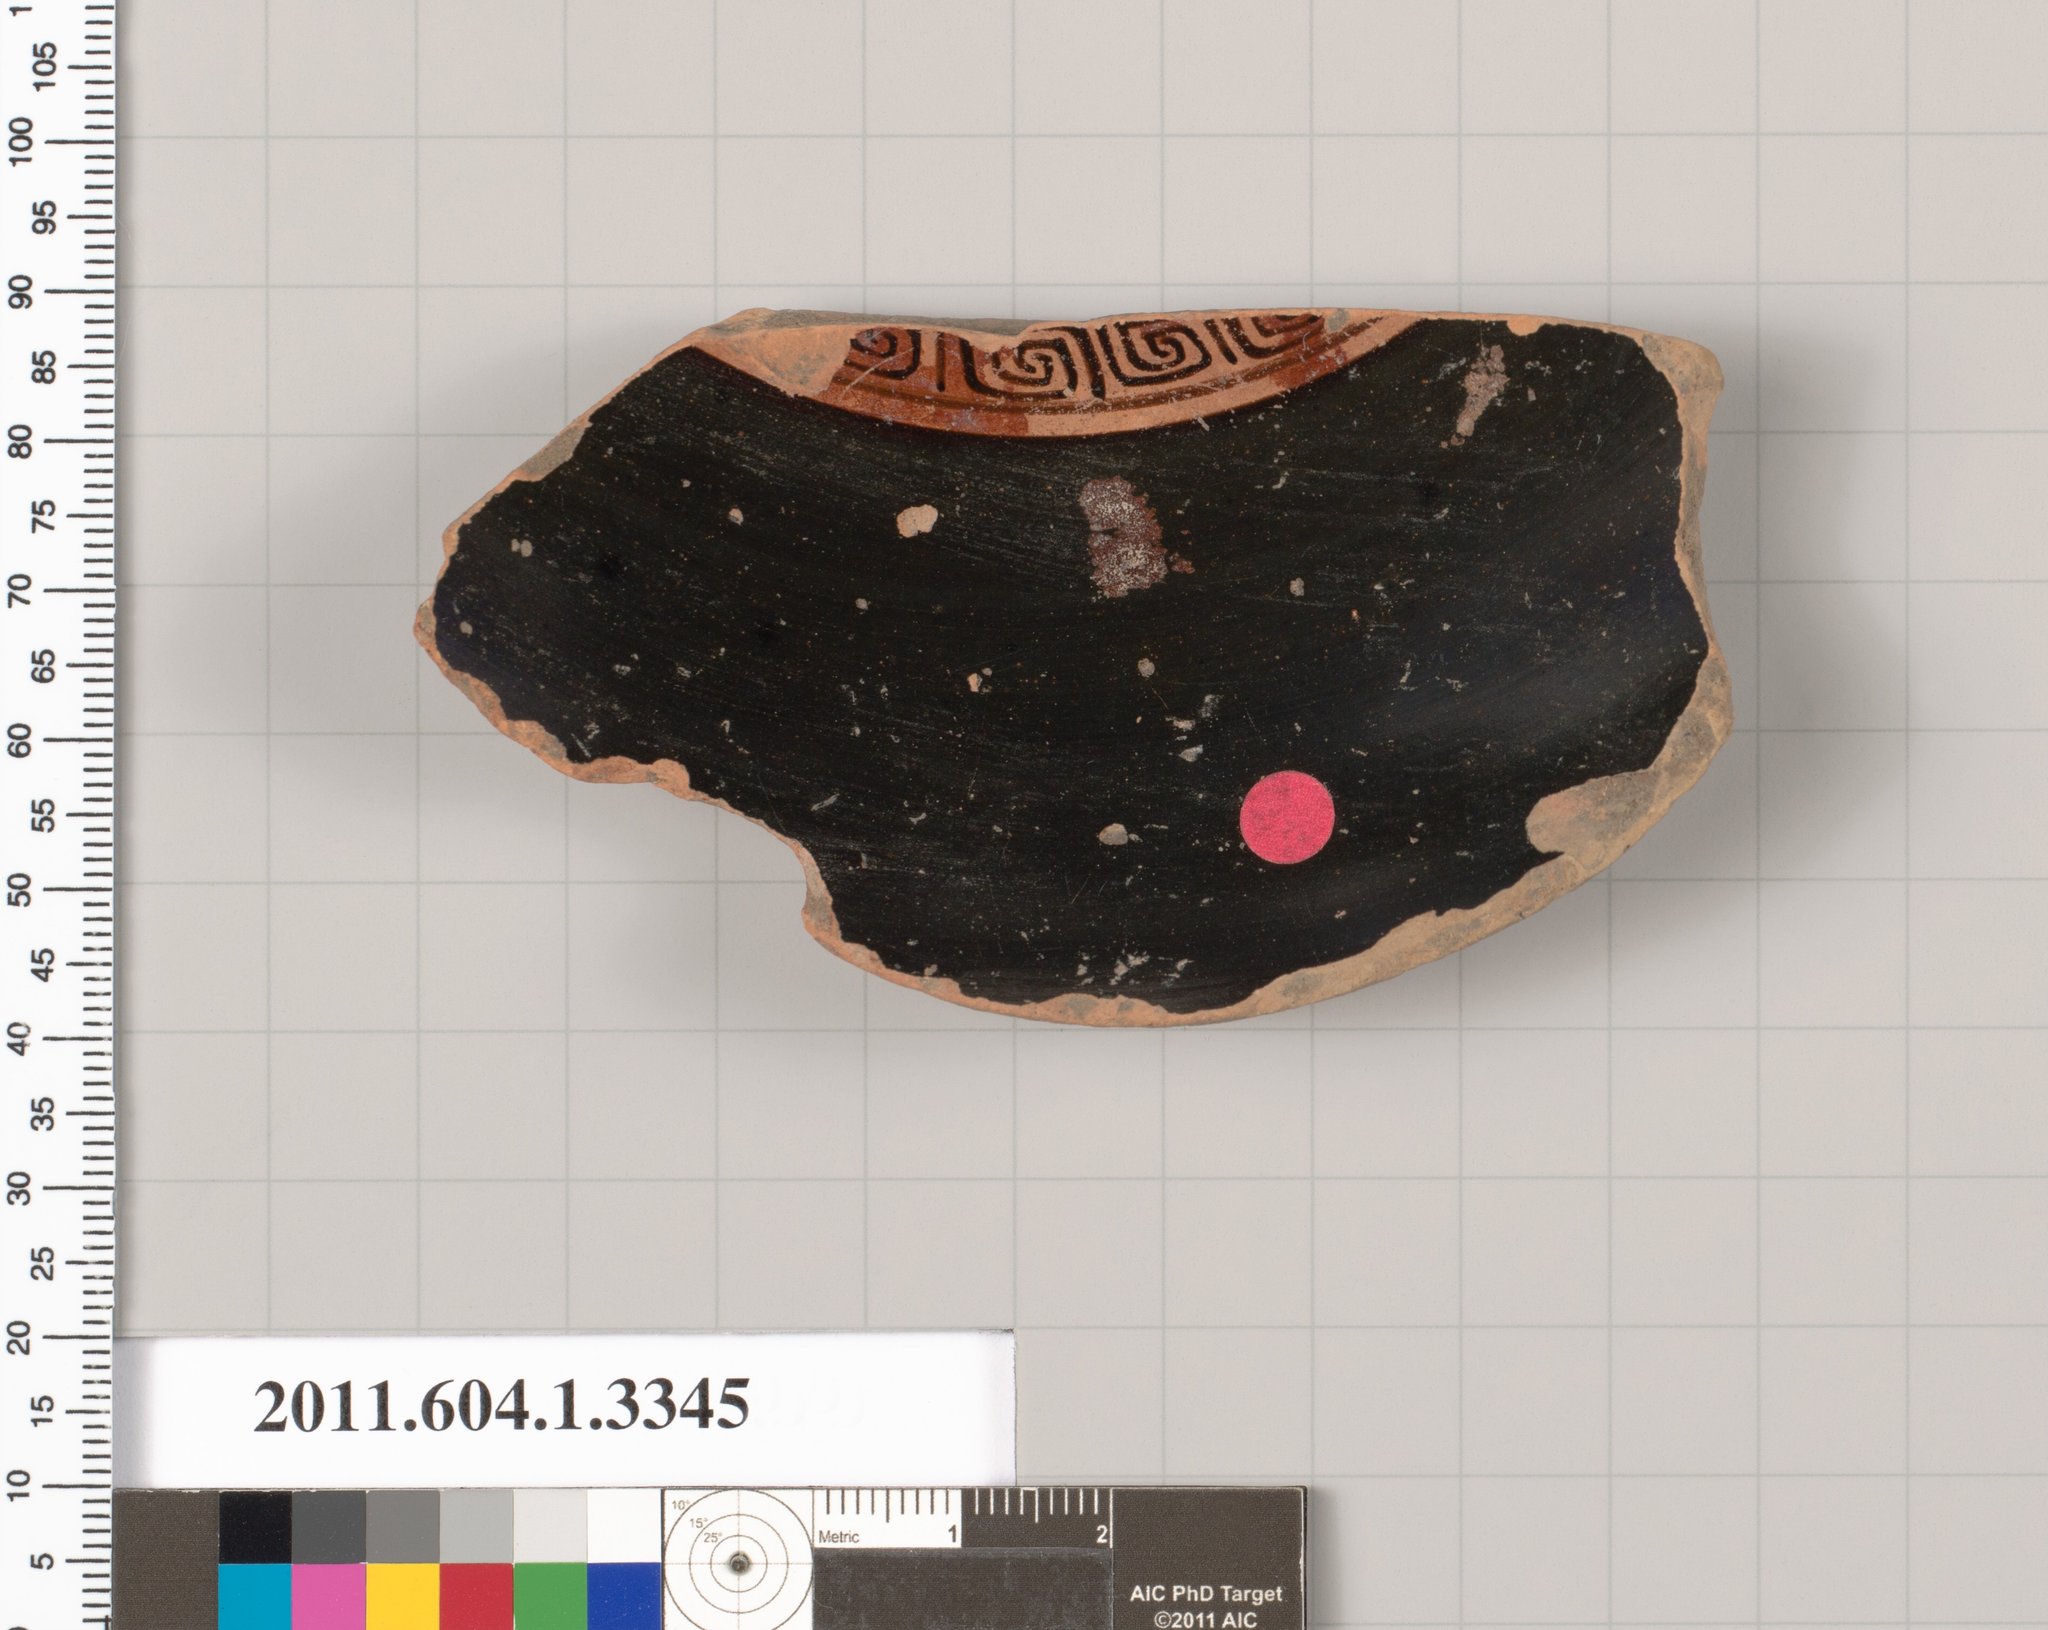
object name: kylix fragment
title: Terracotta fragments of kylikes (drinking cups)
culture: greek, attic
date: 510-470 BCE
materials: terracotta